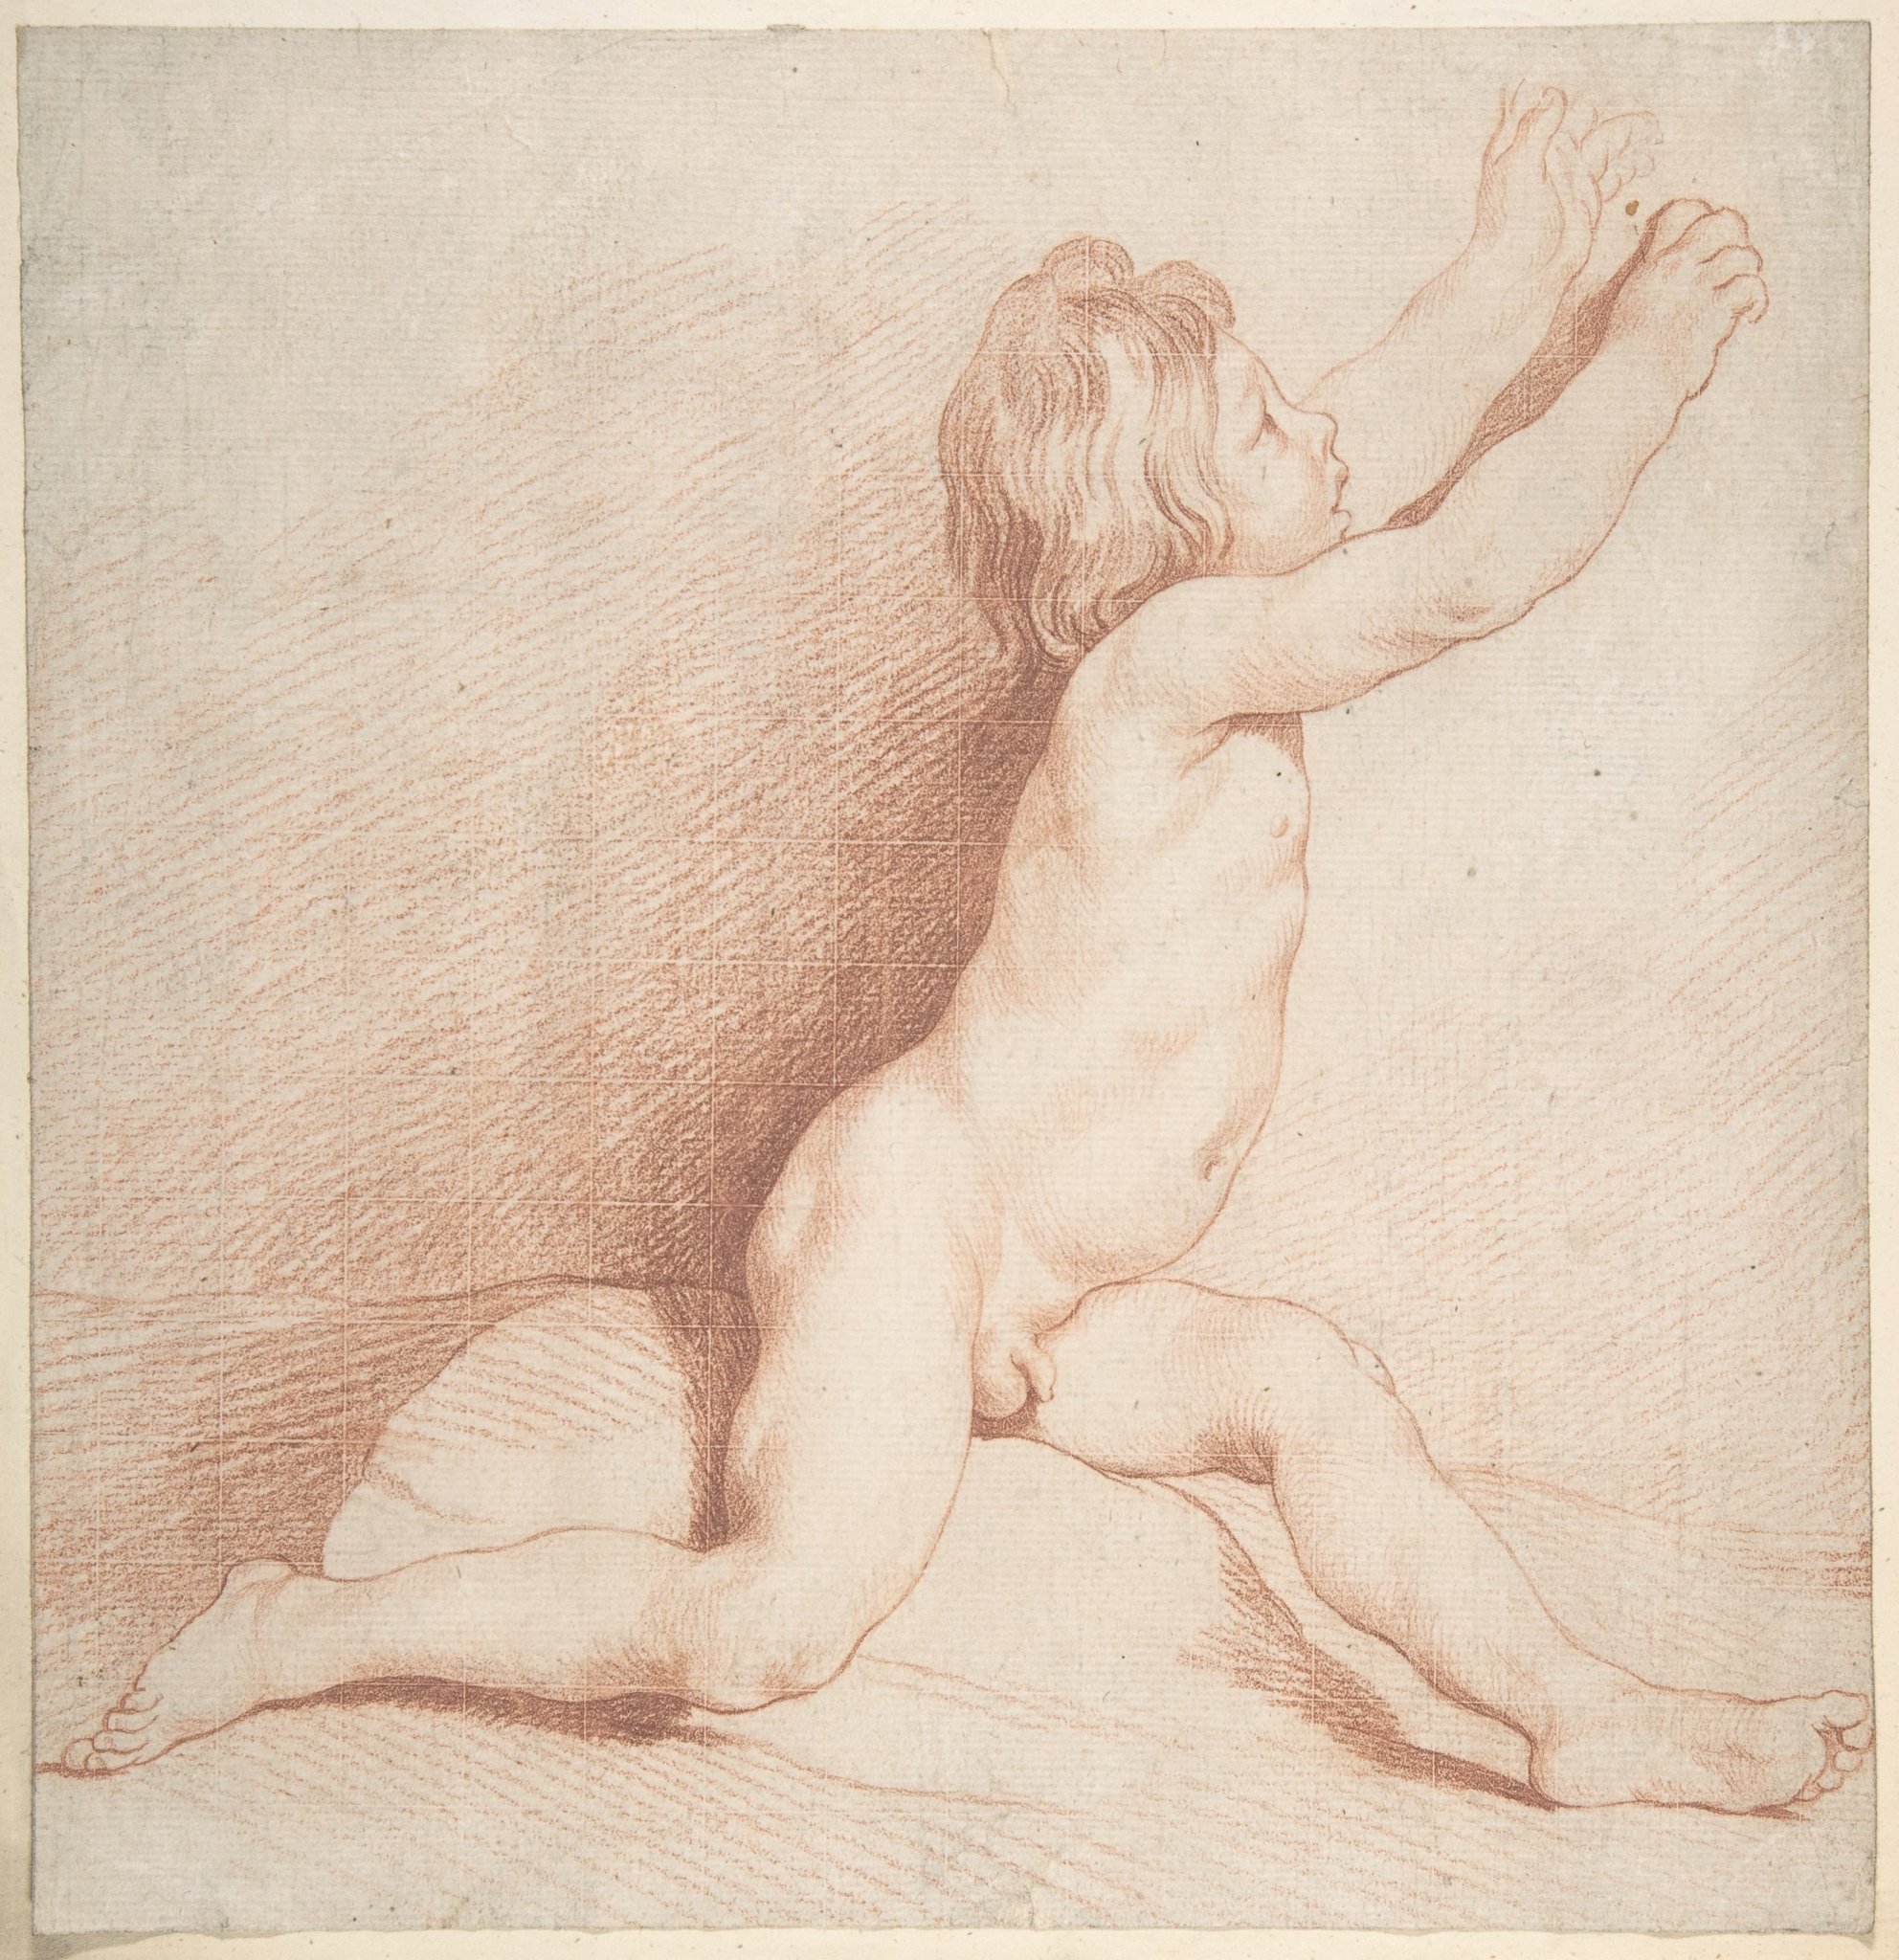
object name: drawing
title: Seated Nude Boy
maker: edme bouchardon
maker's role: artist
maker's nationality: french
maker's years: 1698-1762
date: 1700-1770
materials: chalk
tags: boys,male nudes